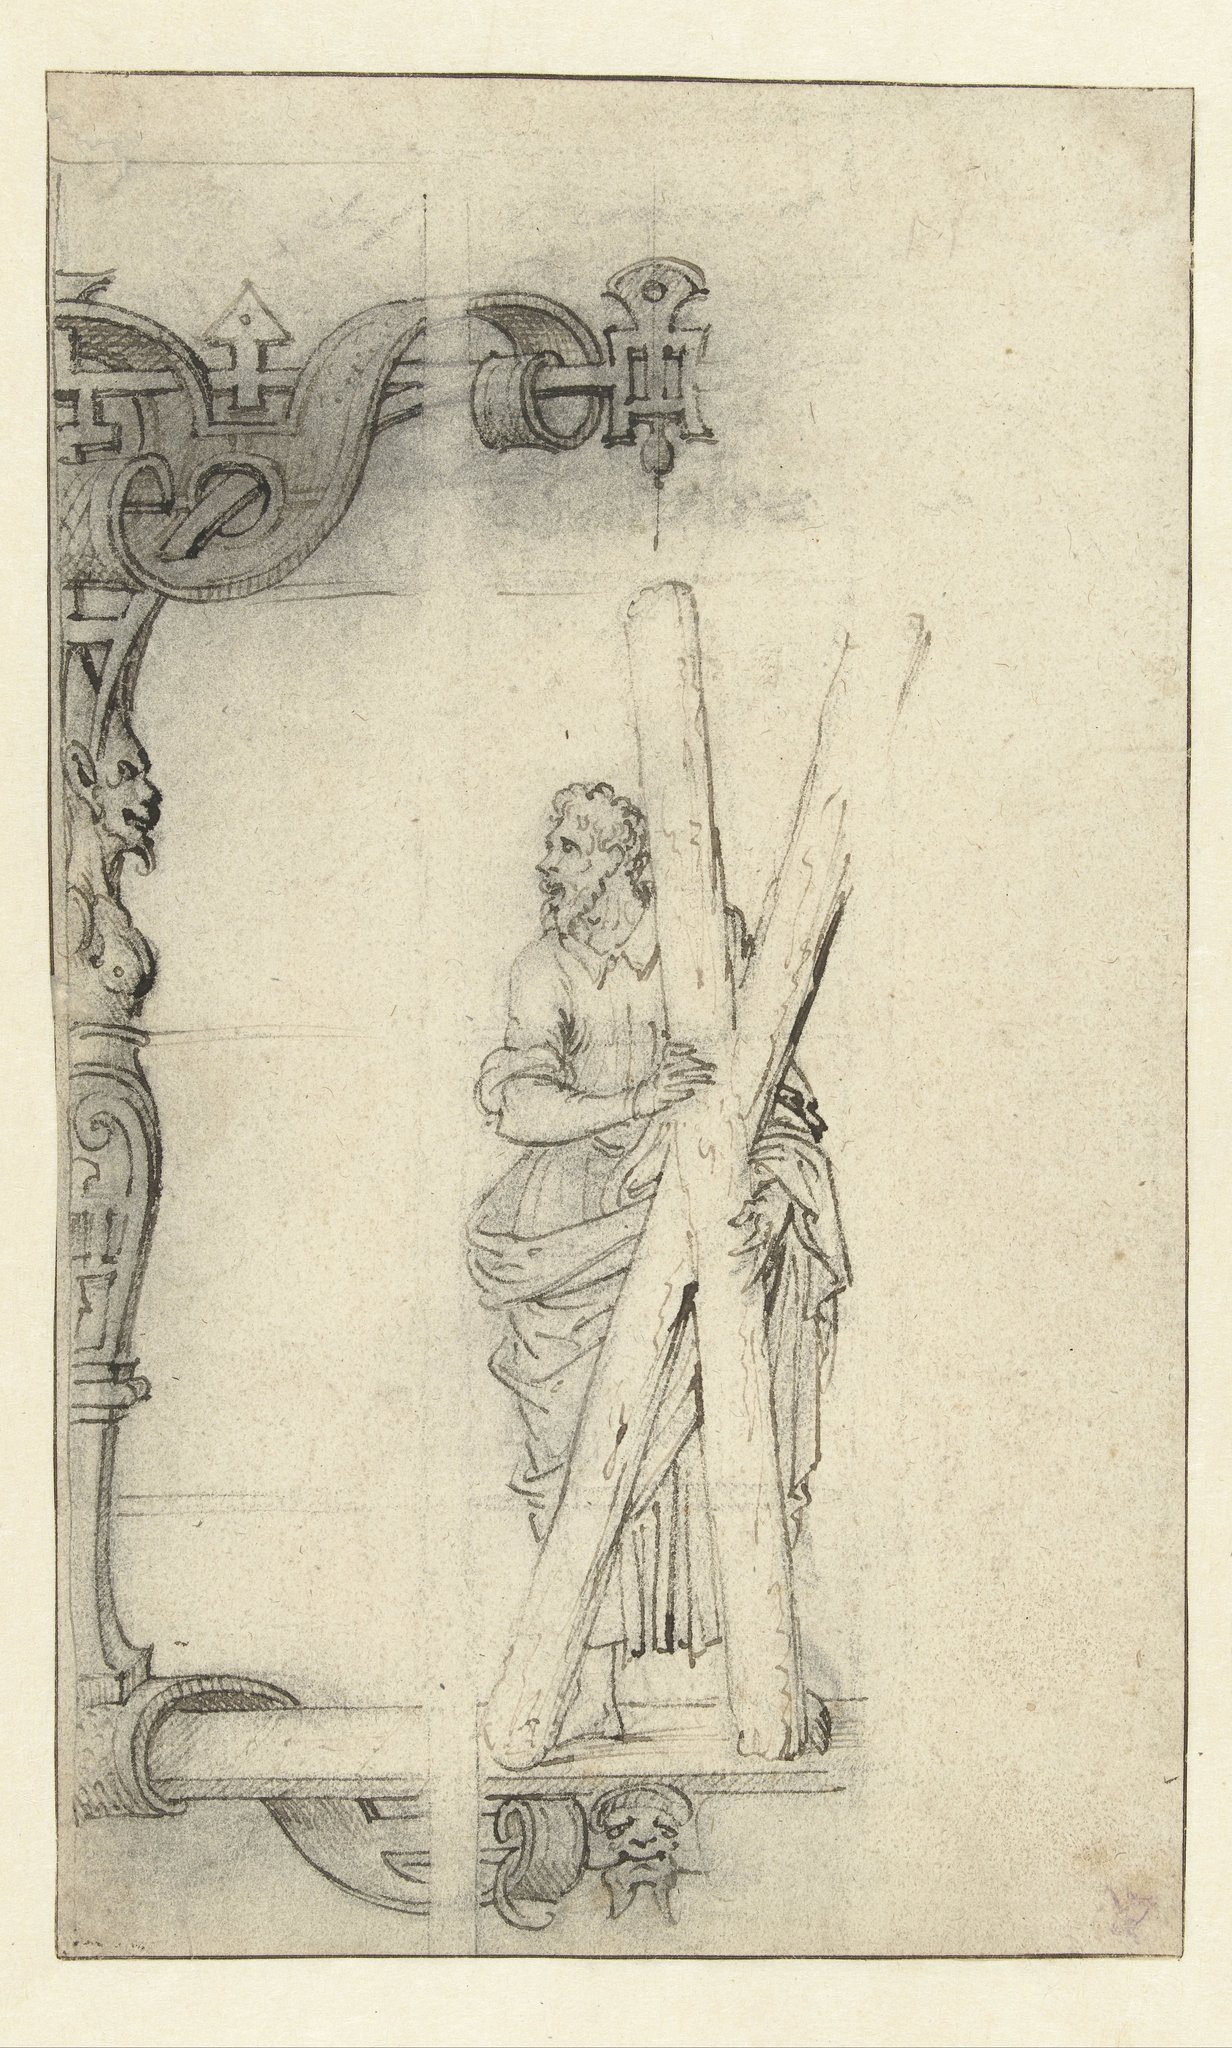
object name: drawing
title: Ontwerptekening voor een gebrandschilderd raam met de Heilige Andreas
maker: dirck pietersz. crabeth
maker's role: draughtsman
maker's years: 1520-1574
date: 1552-1574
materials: chalk, ink, paper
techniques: pen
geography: gouda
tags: the apostle andrew; possible attributes: book, x-shaped cross, fish, fishing-net, rope, scroll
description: Het ontwerp is voor één van de dertien kleine glazen in het koor van de Goudse St. Janskerk.